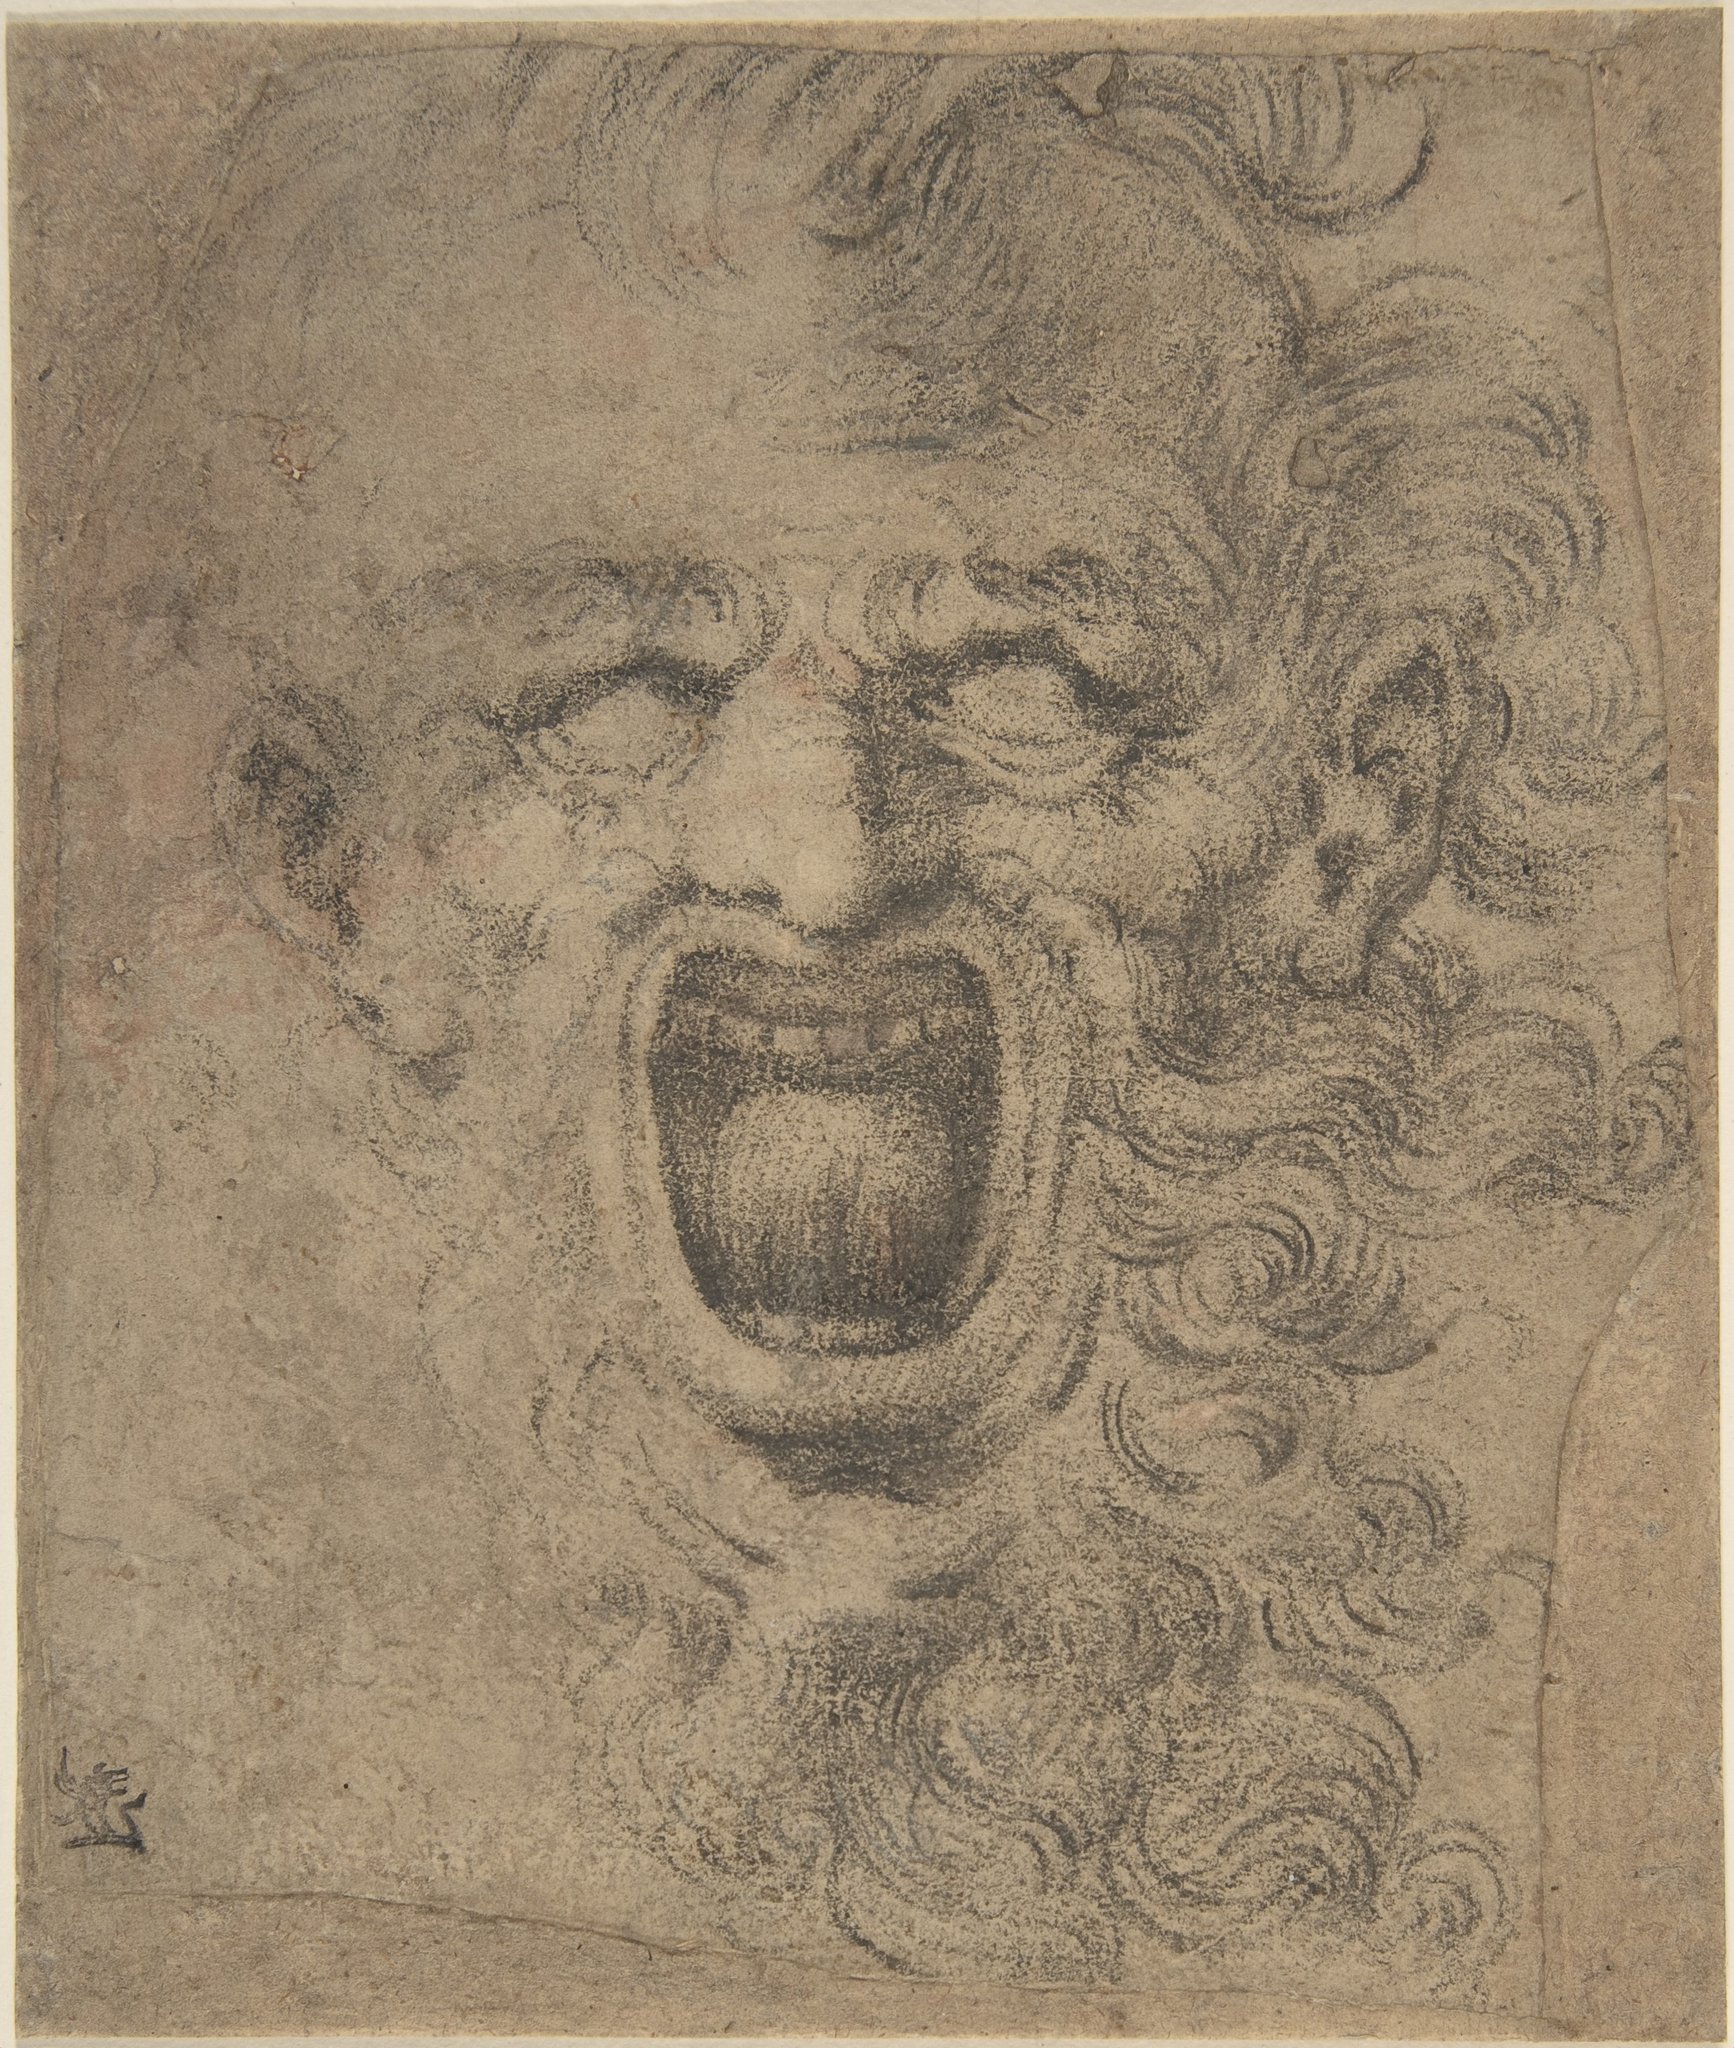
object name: drawing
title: Grotesque Head with Curly Beard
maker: anonymous, italian, 16th to 17th century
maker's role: artist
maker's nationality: italian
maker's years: 1500-1700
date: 1501-1700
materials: chalk, graphite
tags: heads,men